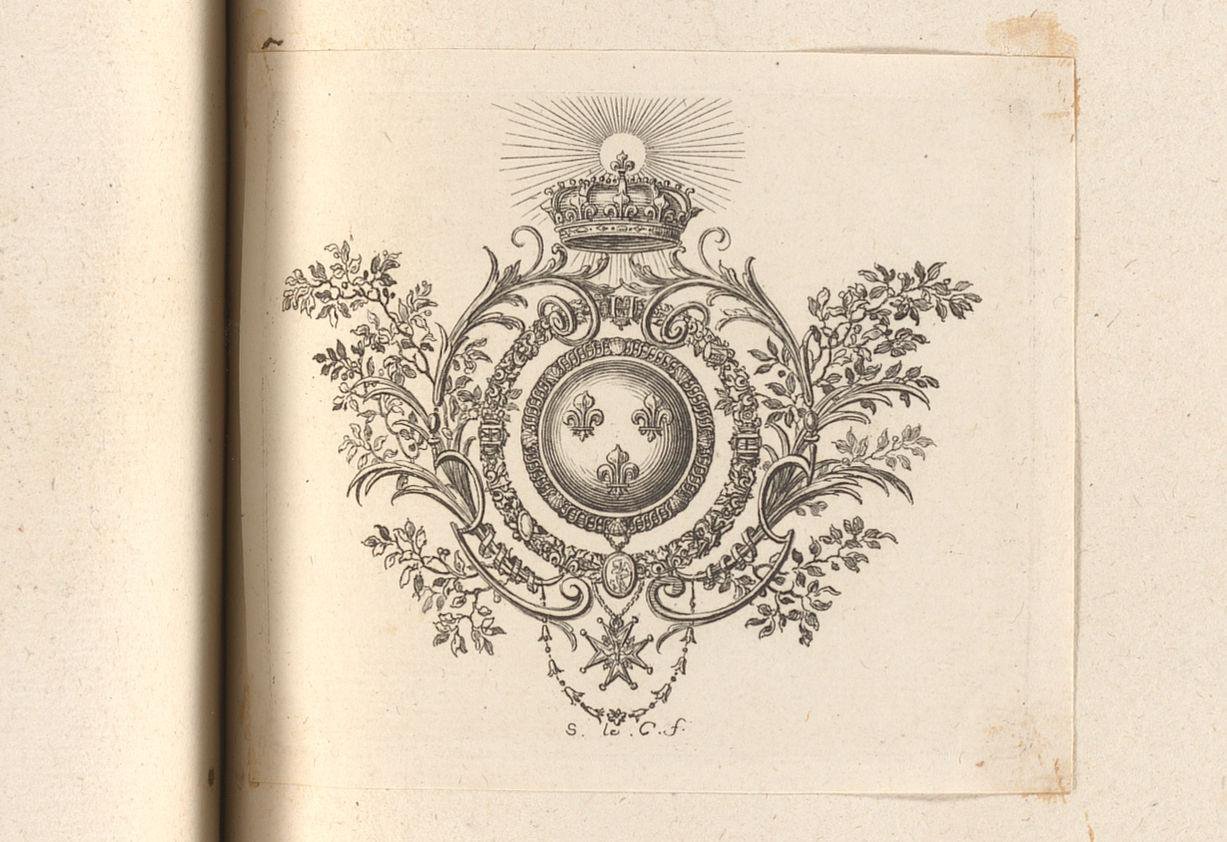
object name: print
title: Cul-de-lampe met koninklijke insigne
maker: sébastien leclerc (i)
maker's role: print maker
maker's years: 1637-1714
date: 1703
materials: paper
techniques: etching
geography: paris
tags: insignia and symbols of sovereignty (crown, diadem, sceptre, orb, seal, standard, cloak, pectoral)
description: Prent gebruikt voor: Les Statuts de l'ordre du Saint-Esprit. Parijs: Imprimerie Royale, 1703.